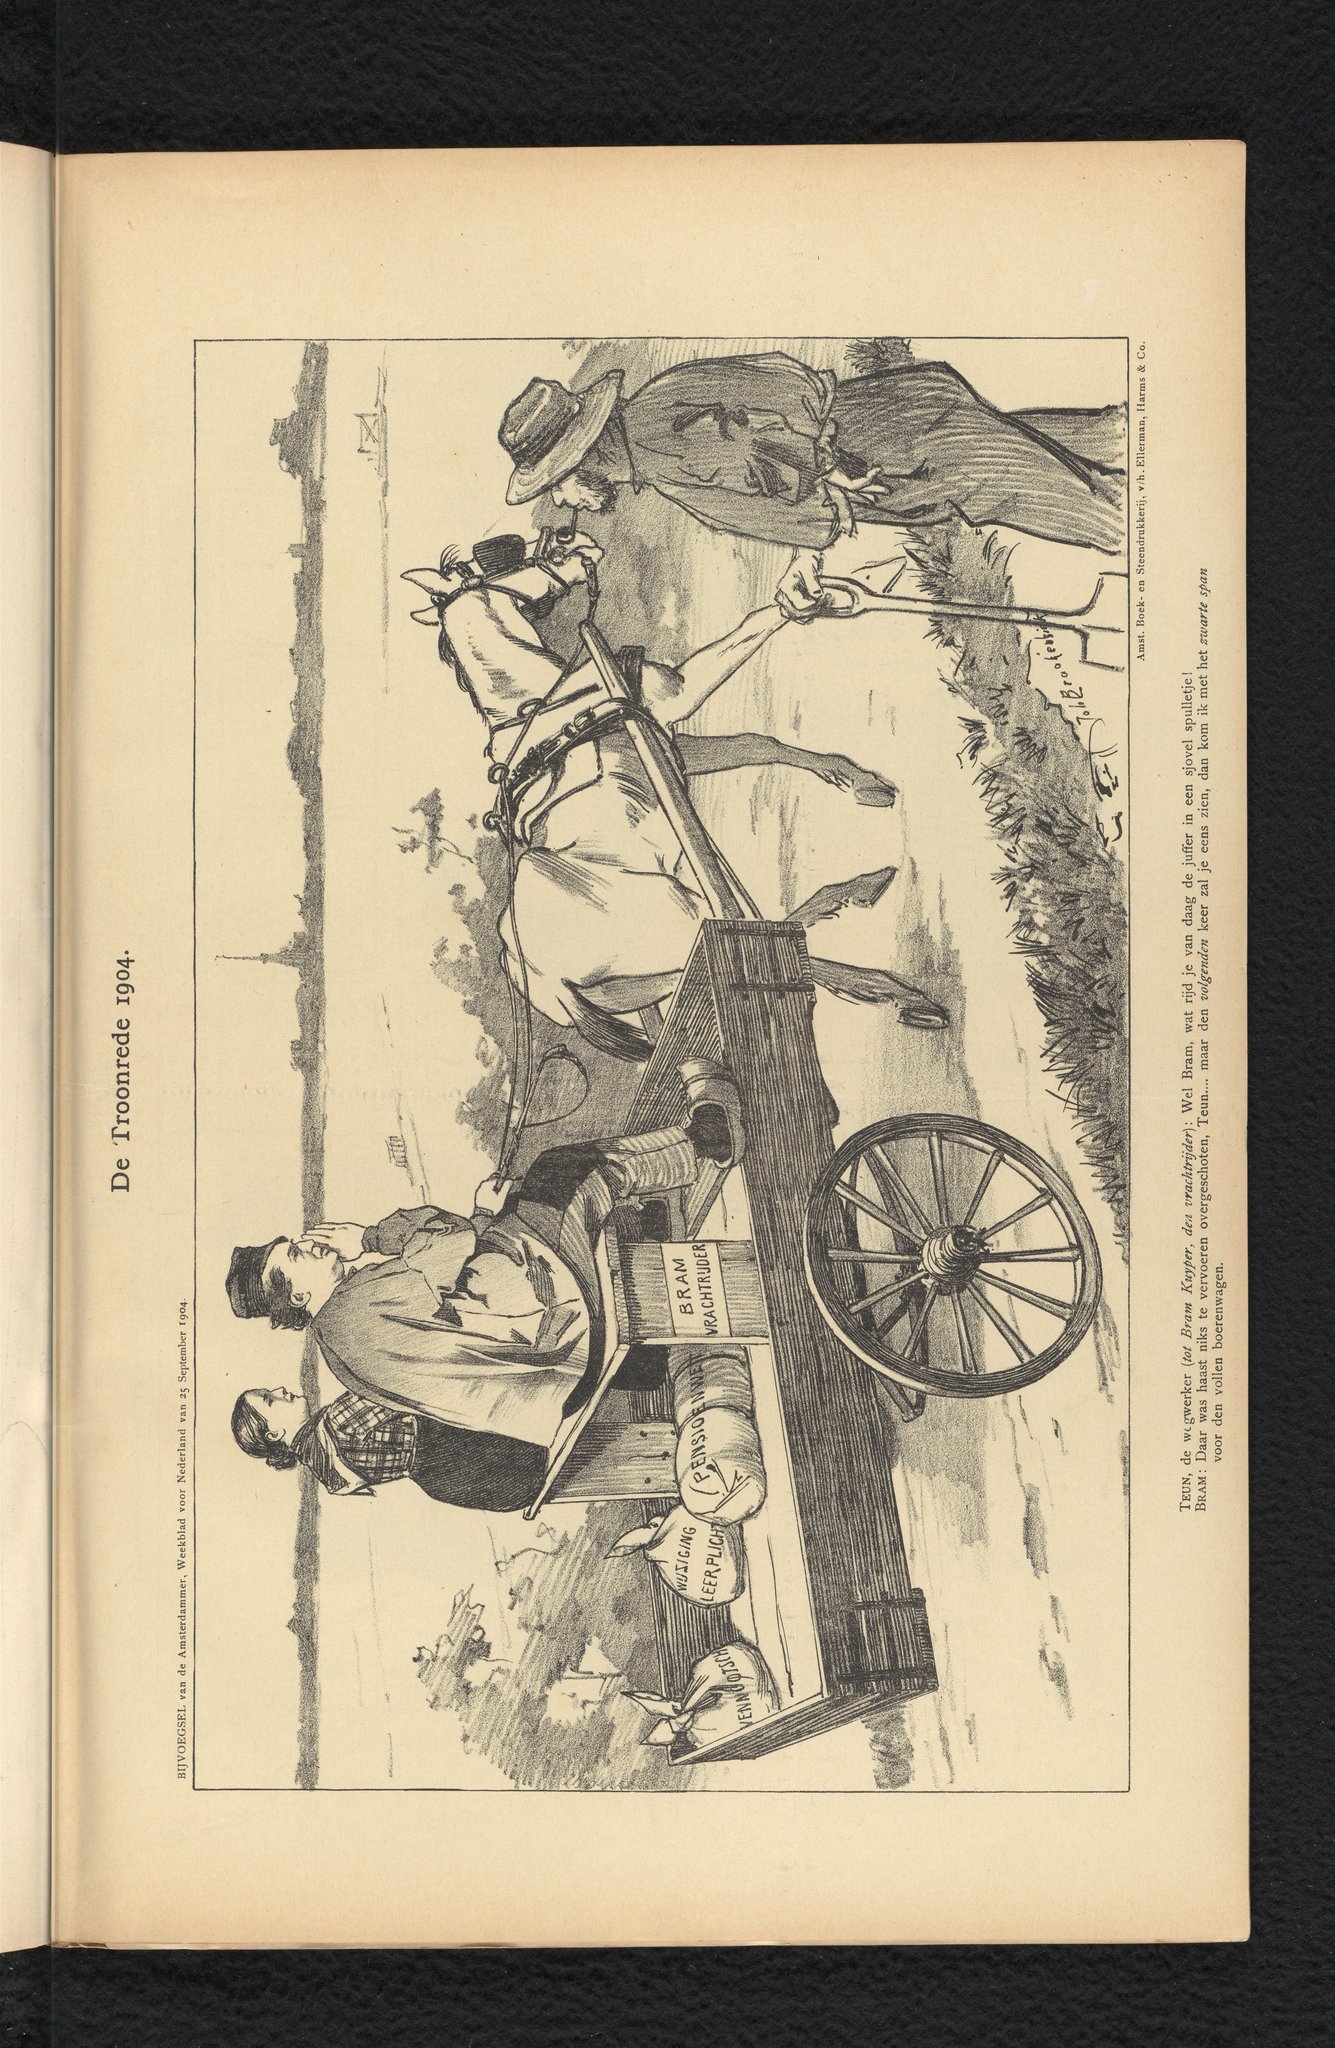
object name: cartoon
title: De Troonrede 1904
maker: johan braakensiek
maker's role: draughtsman, print maker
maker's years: 1858-1940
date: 1904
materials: paper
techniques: lithograph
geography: amsterdam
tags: the hague, abraham kuyper, personifications of countries, nations, states, districts, etc., two-wheeled vehicle drawn by one animal, political caricatures and satires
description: Premier Abraham Kuyper als vrachtrijder onderweg in een wagen met een jonge vrouw (waarschijnlijk de Nederlandse Maagd) aangesproken door een wegwerker langs de kant van de weg. In de kar liggen slechts een paar pakketten, verwijzend maar de magere inhoud van de troonrede.